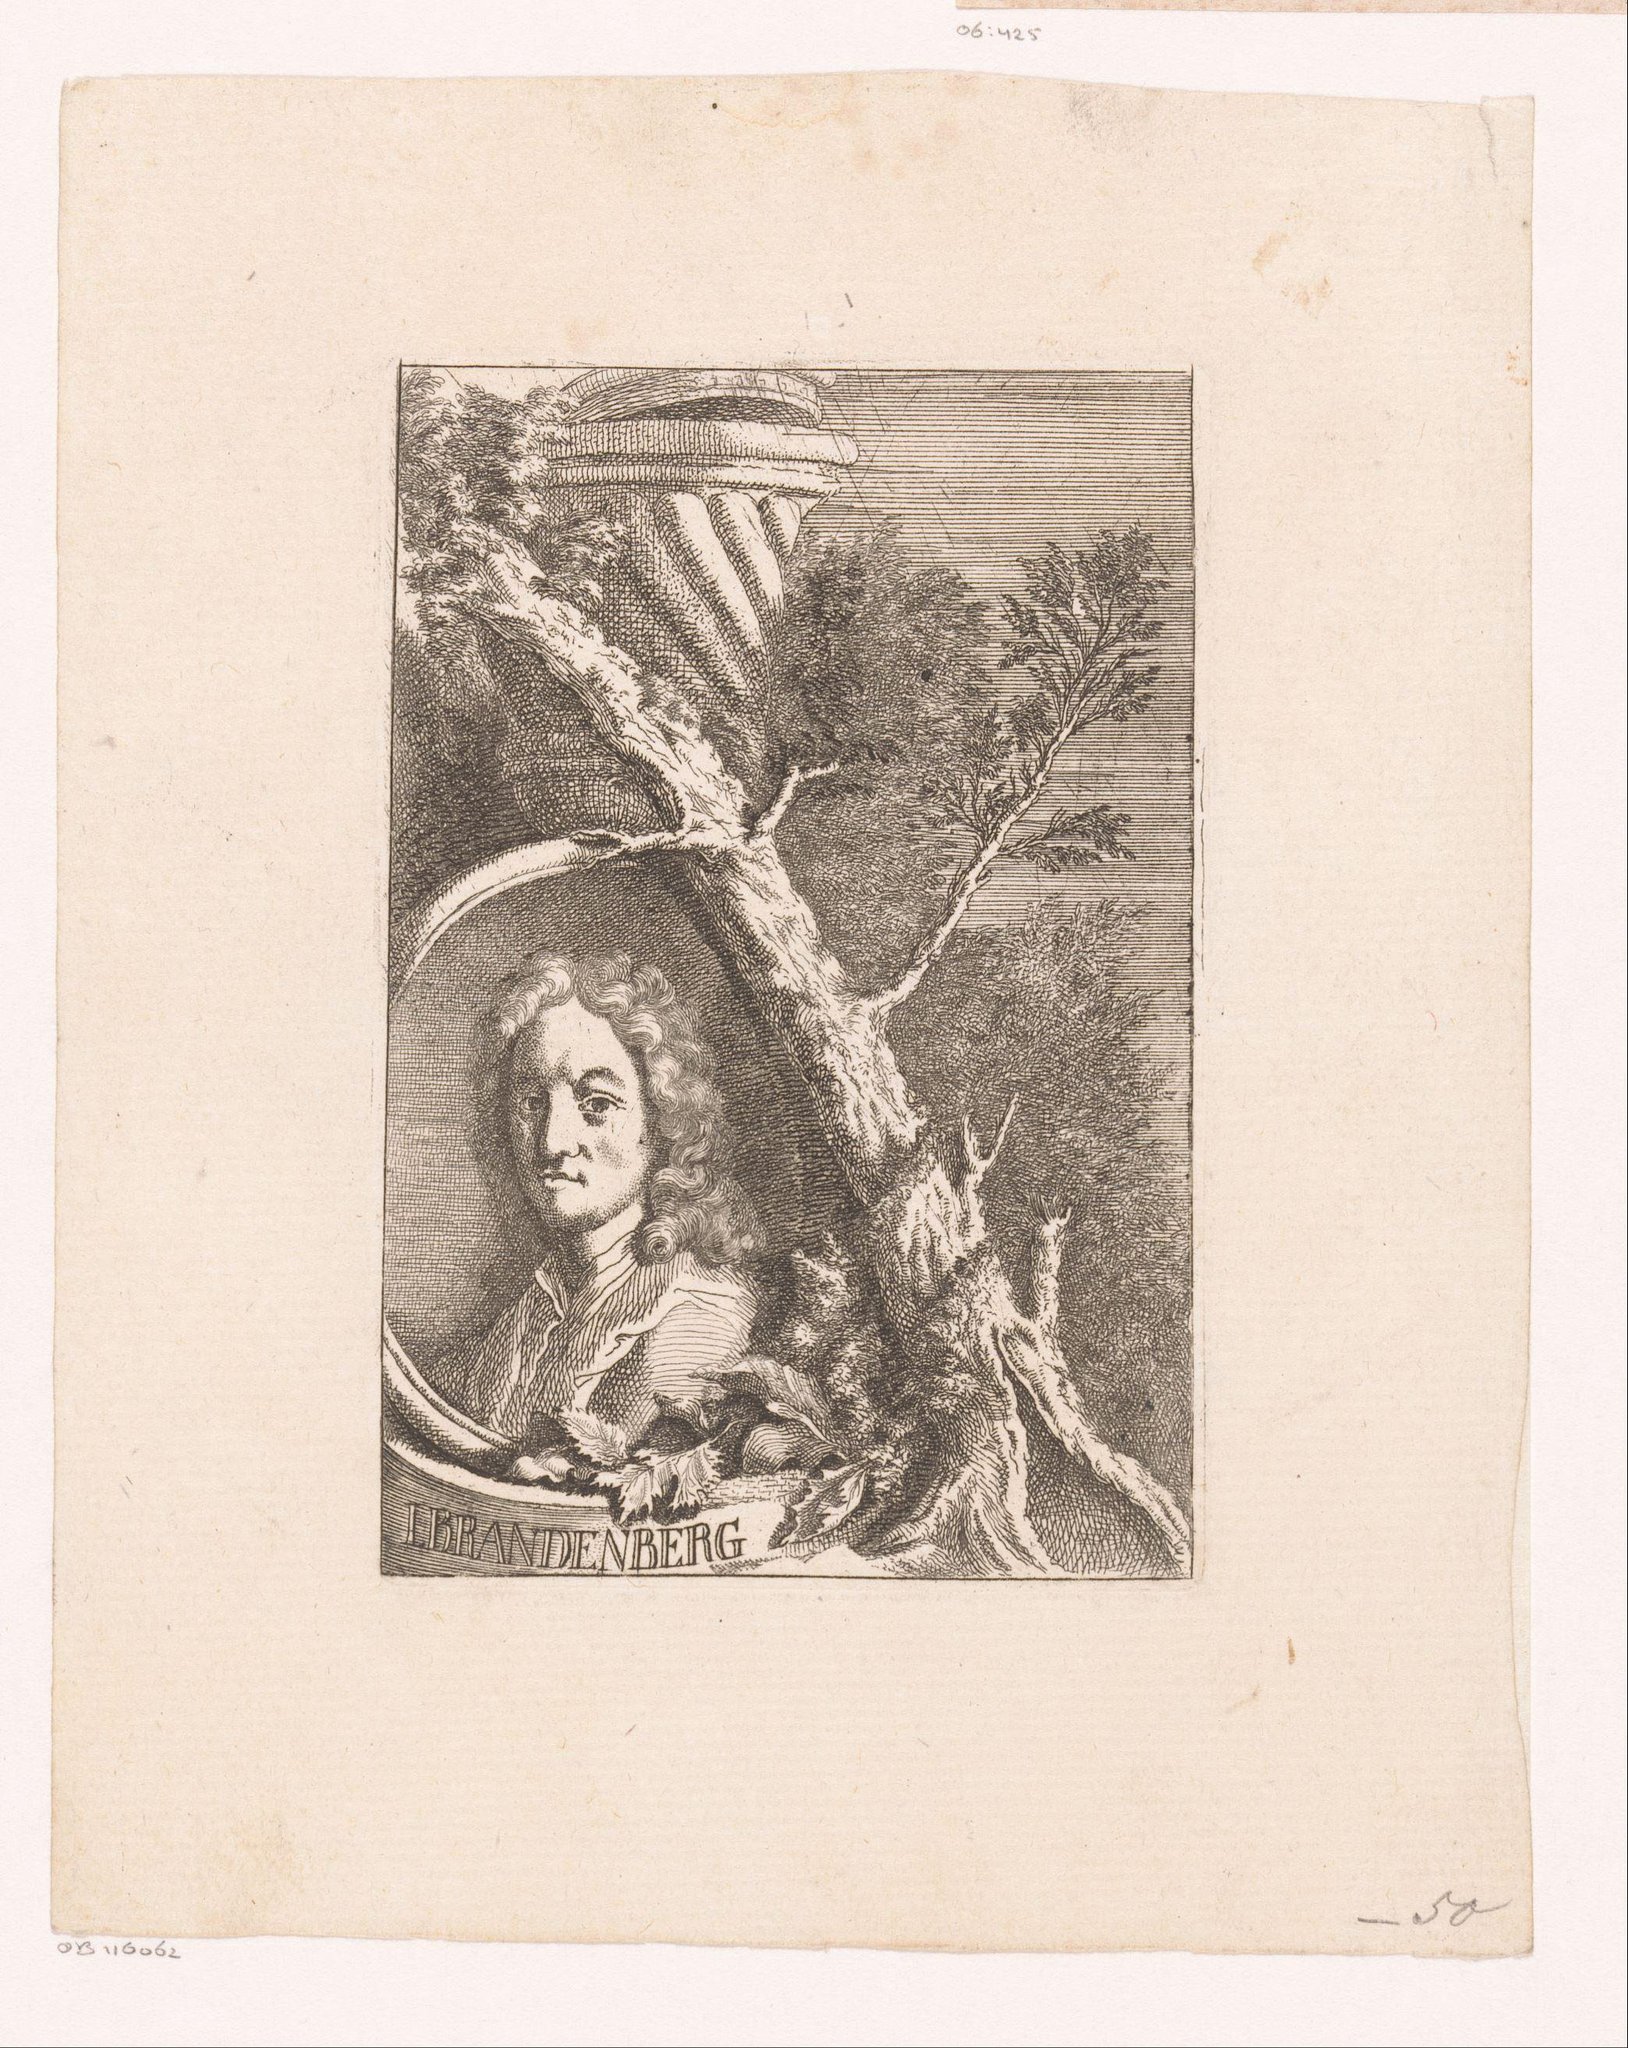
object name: print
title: Portret van Johannes Brandenberg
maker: rudolf füssli (der jüngste)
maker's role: print maker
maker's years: 1737-1806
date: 1755-1757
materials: paper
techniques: etching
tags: painter, plants; vegetation, column, pillar ~ architecture, ornament ~ medallion, portrait, self-portrait of painter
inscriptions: collector's mark: Lugt 2228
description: Prent gebruikt voor: Füssli, Johann Kaspar. Geschichte Und Abbildung der besten Mahler in der Schweitz. Zürich: David Gessner, 1755-1757.